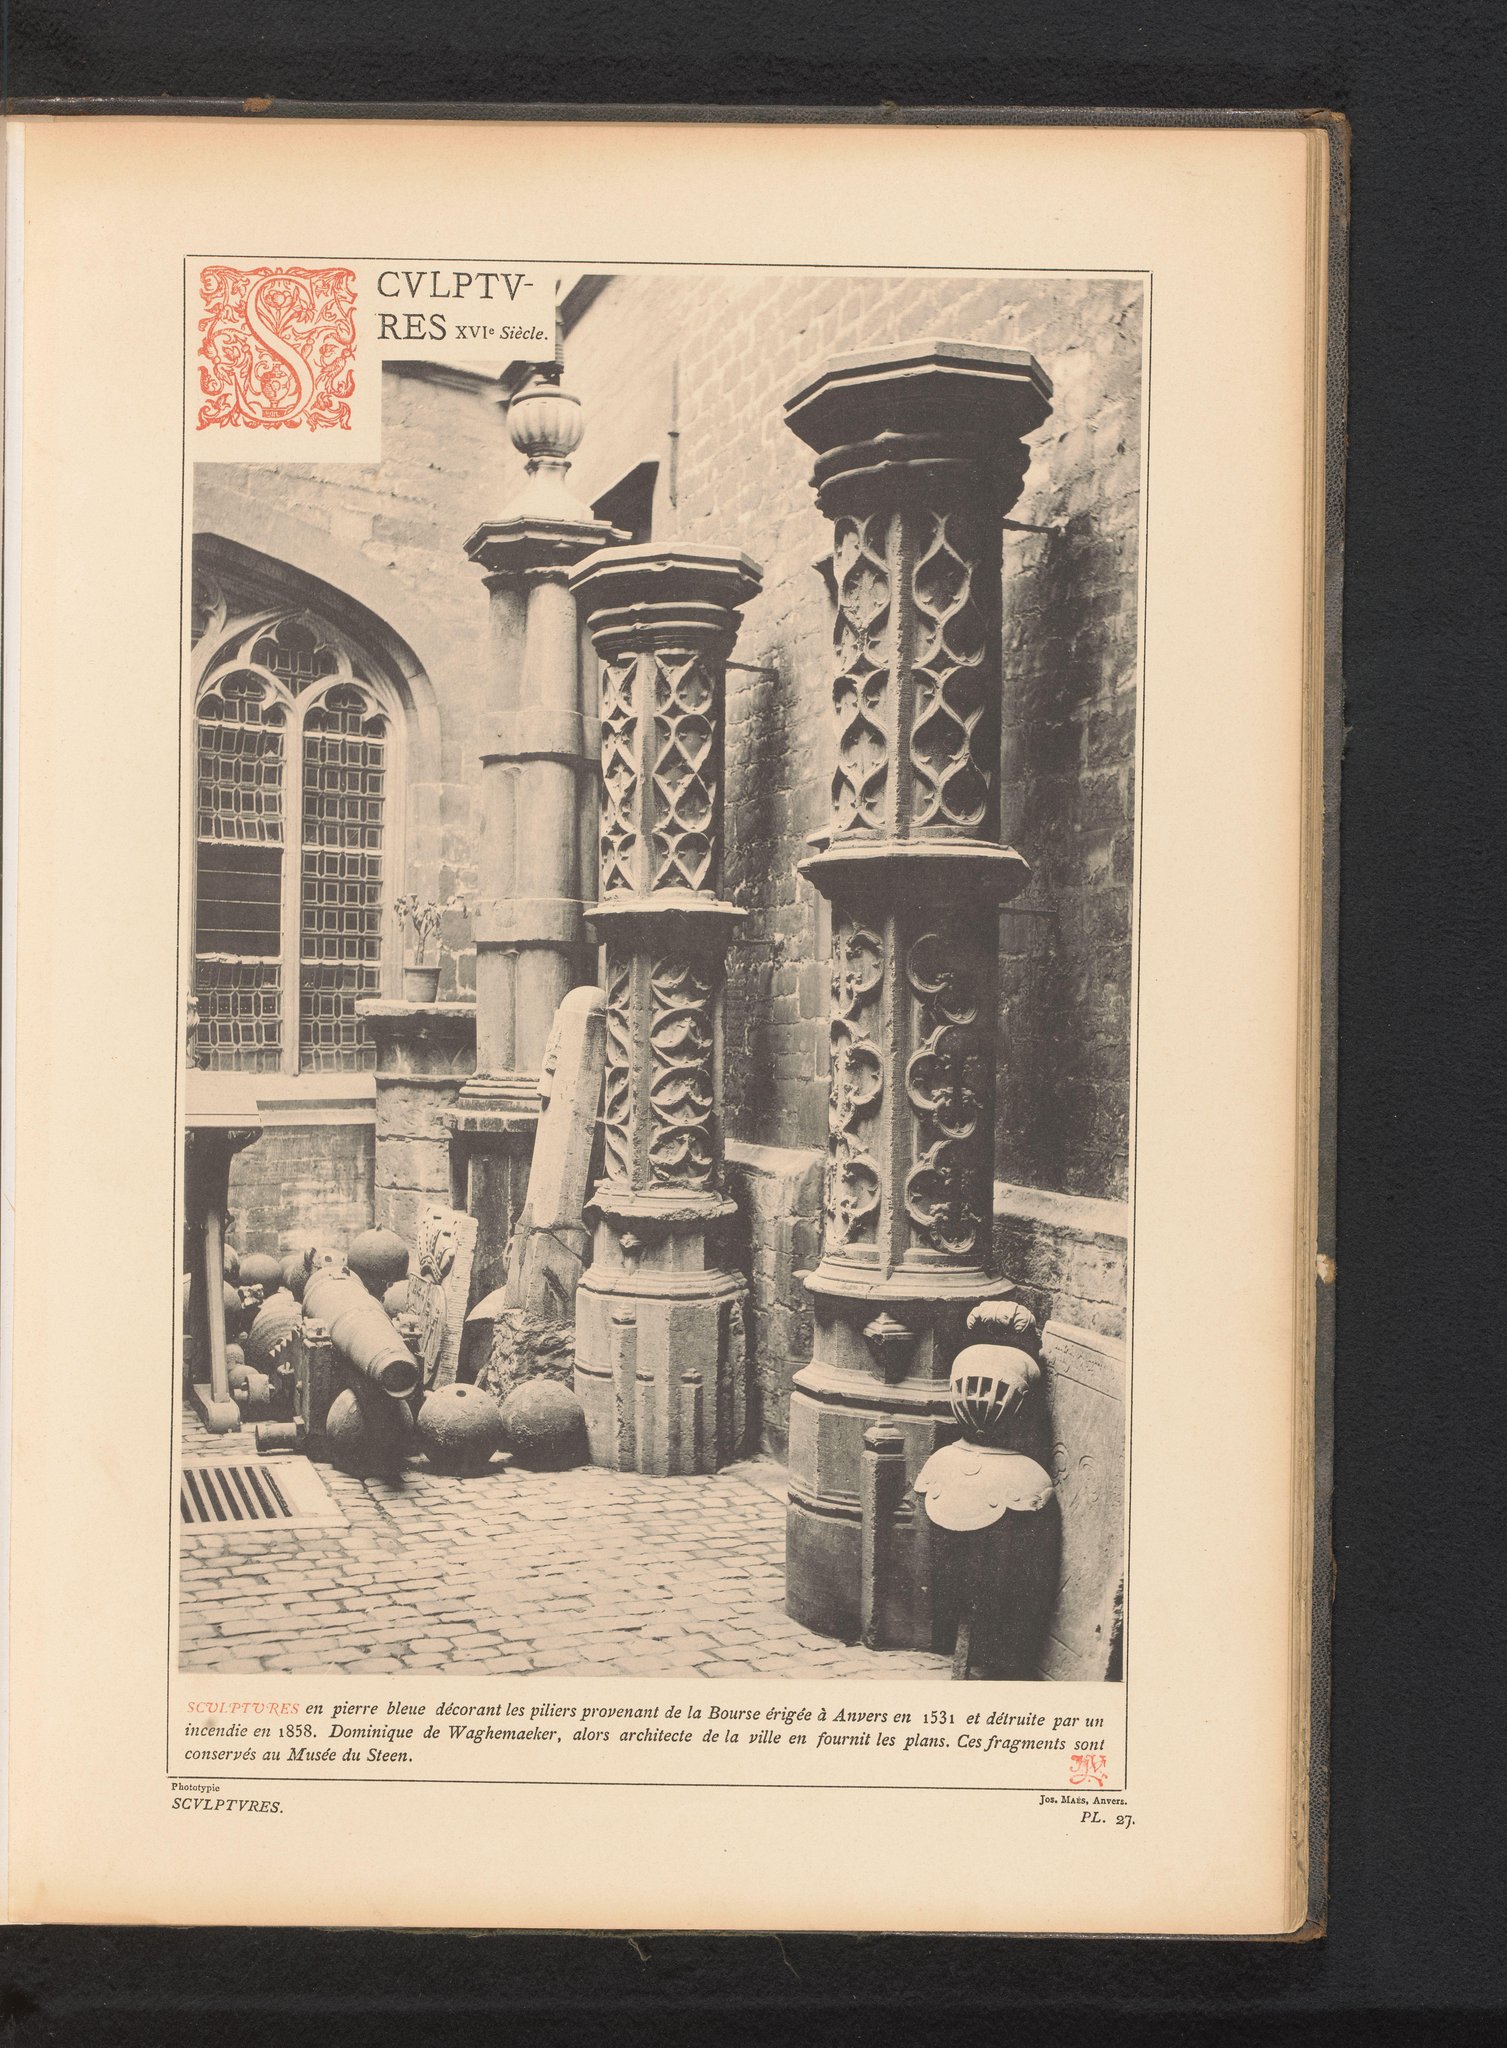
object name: photomechanical print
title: Sculptures, XVIe Siècle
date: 1881-1889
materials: paper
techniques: photograph, photolithography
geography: antwerp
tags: column, pillar ~ architecture, sculpture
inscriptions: monogram: ‘JJvY’, inscription: ‘SCULPTURES. PL. 27.’, inscription: ‘SCULPTURES en pierre (...)’